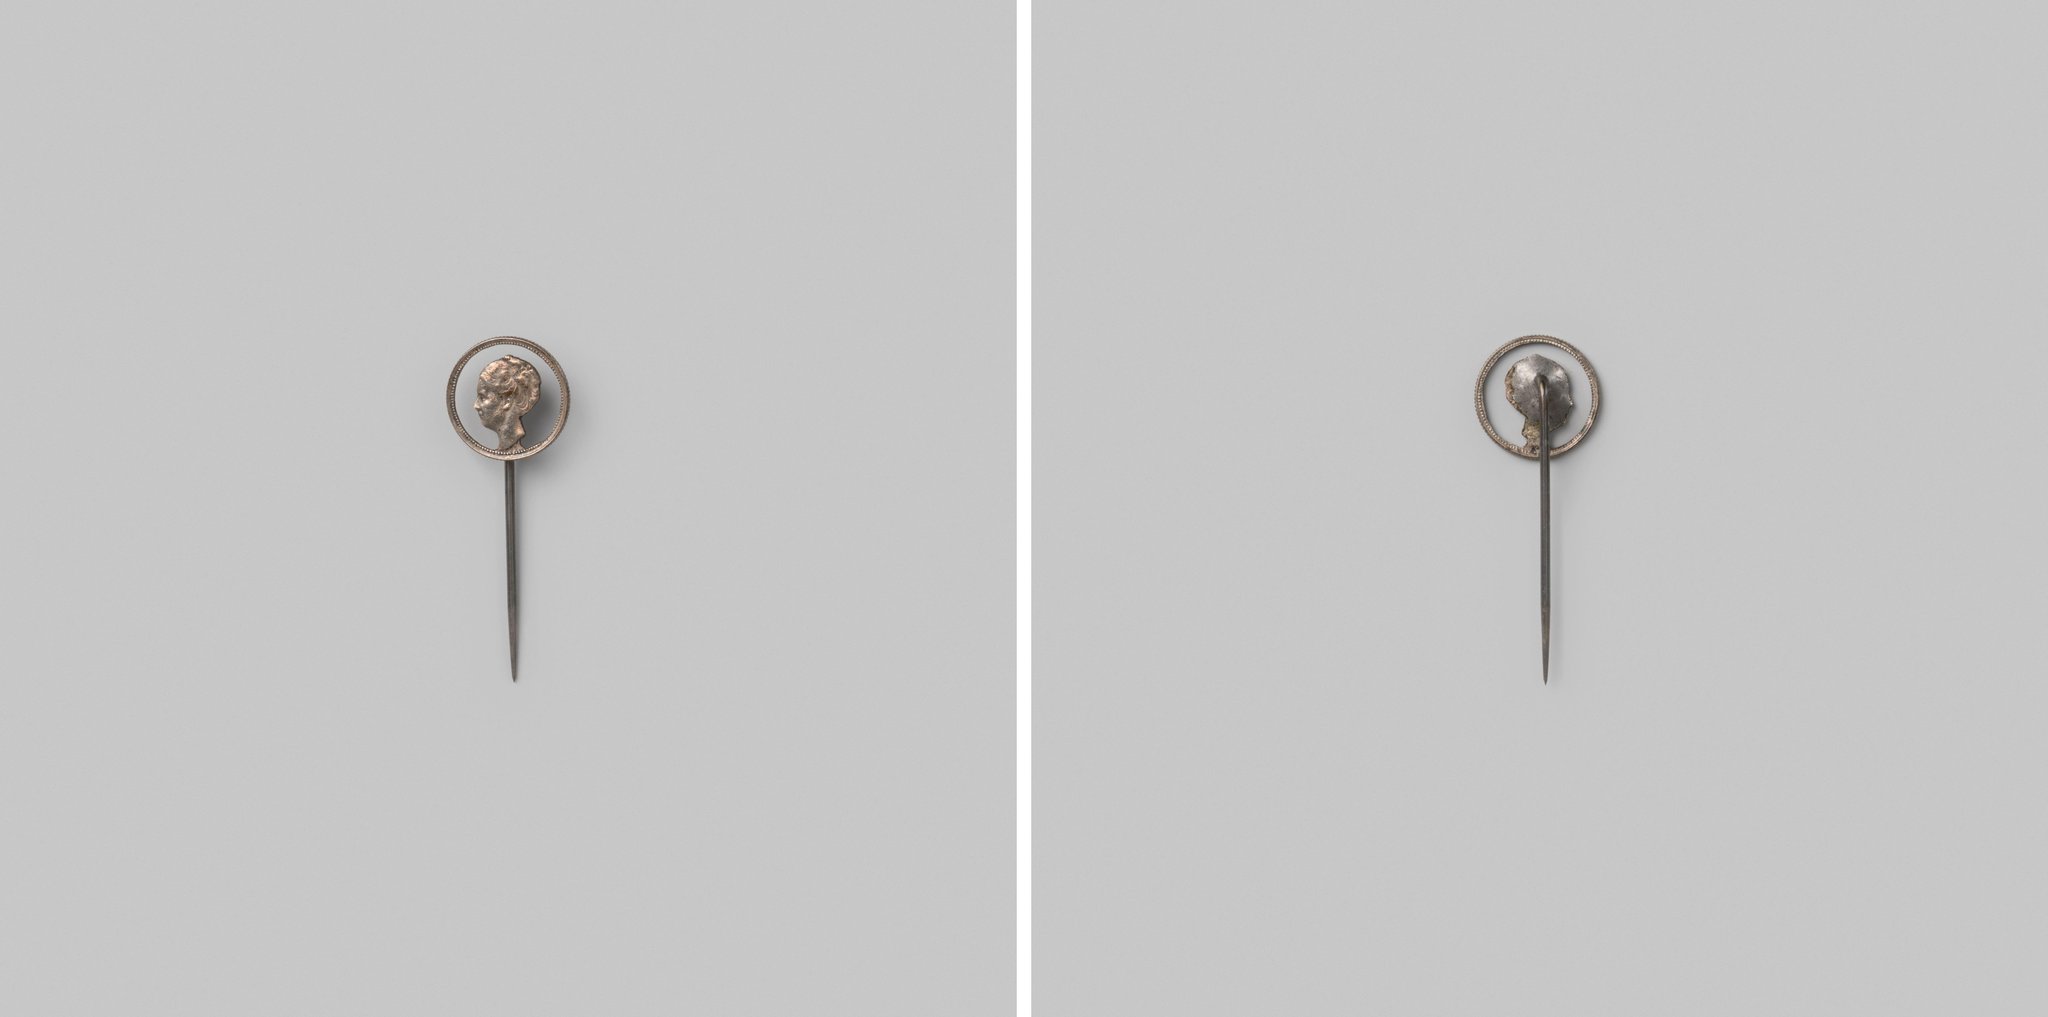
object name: dubbeltje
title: Dubbeltje, Wilhelmina, koningin der Nederlanden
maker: Anonymous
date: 1914-1945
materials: silver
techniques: soldering, striking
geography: utrecht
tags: the hague, wilhelmina of the netherlands, netherlands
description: Zilveren insigne, vervaardigd uit ajour bewerkte munt, waarvan alleen beeldenaar en rand zijn overgelaten; hieraan is aan achterzijde speld gesoldeerd. Voorzijde: borststuk van koningin Wilhelmina in profiel naar links, in haar haar een kleine diadeem omgeven door een parelrand. Keerzijde: blanco.